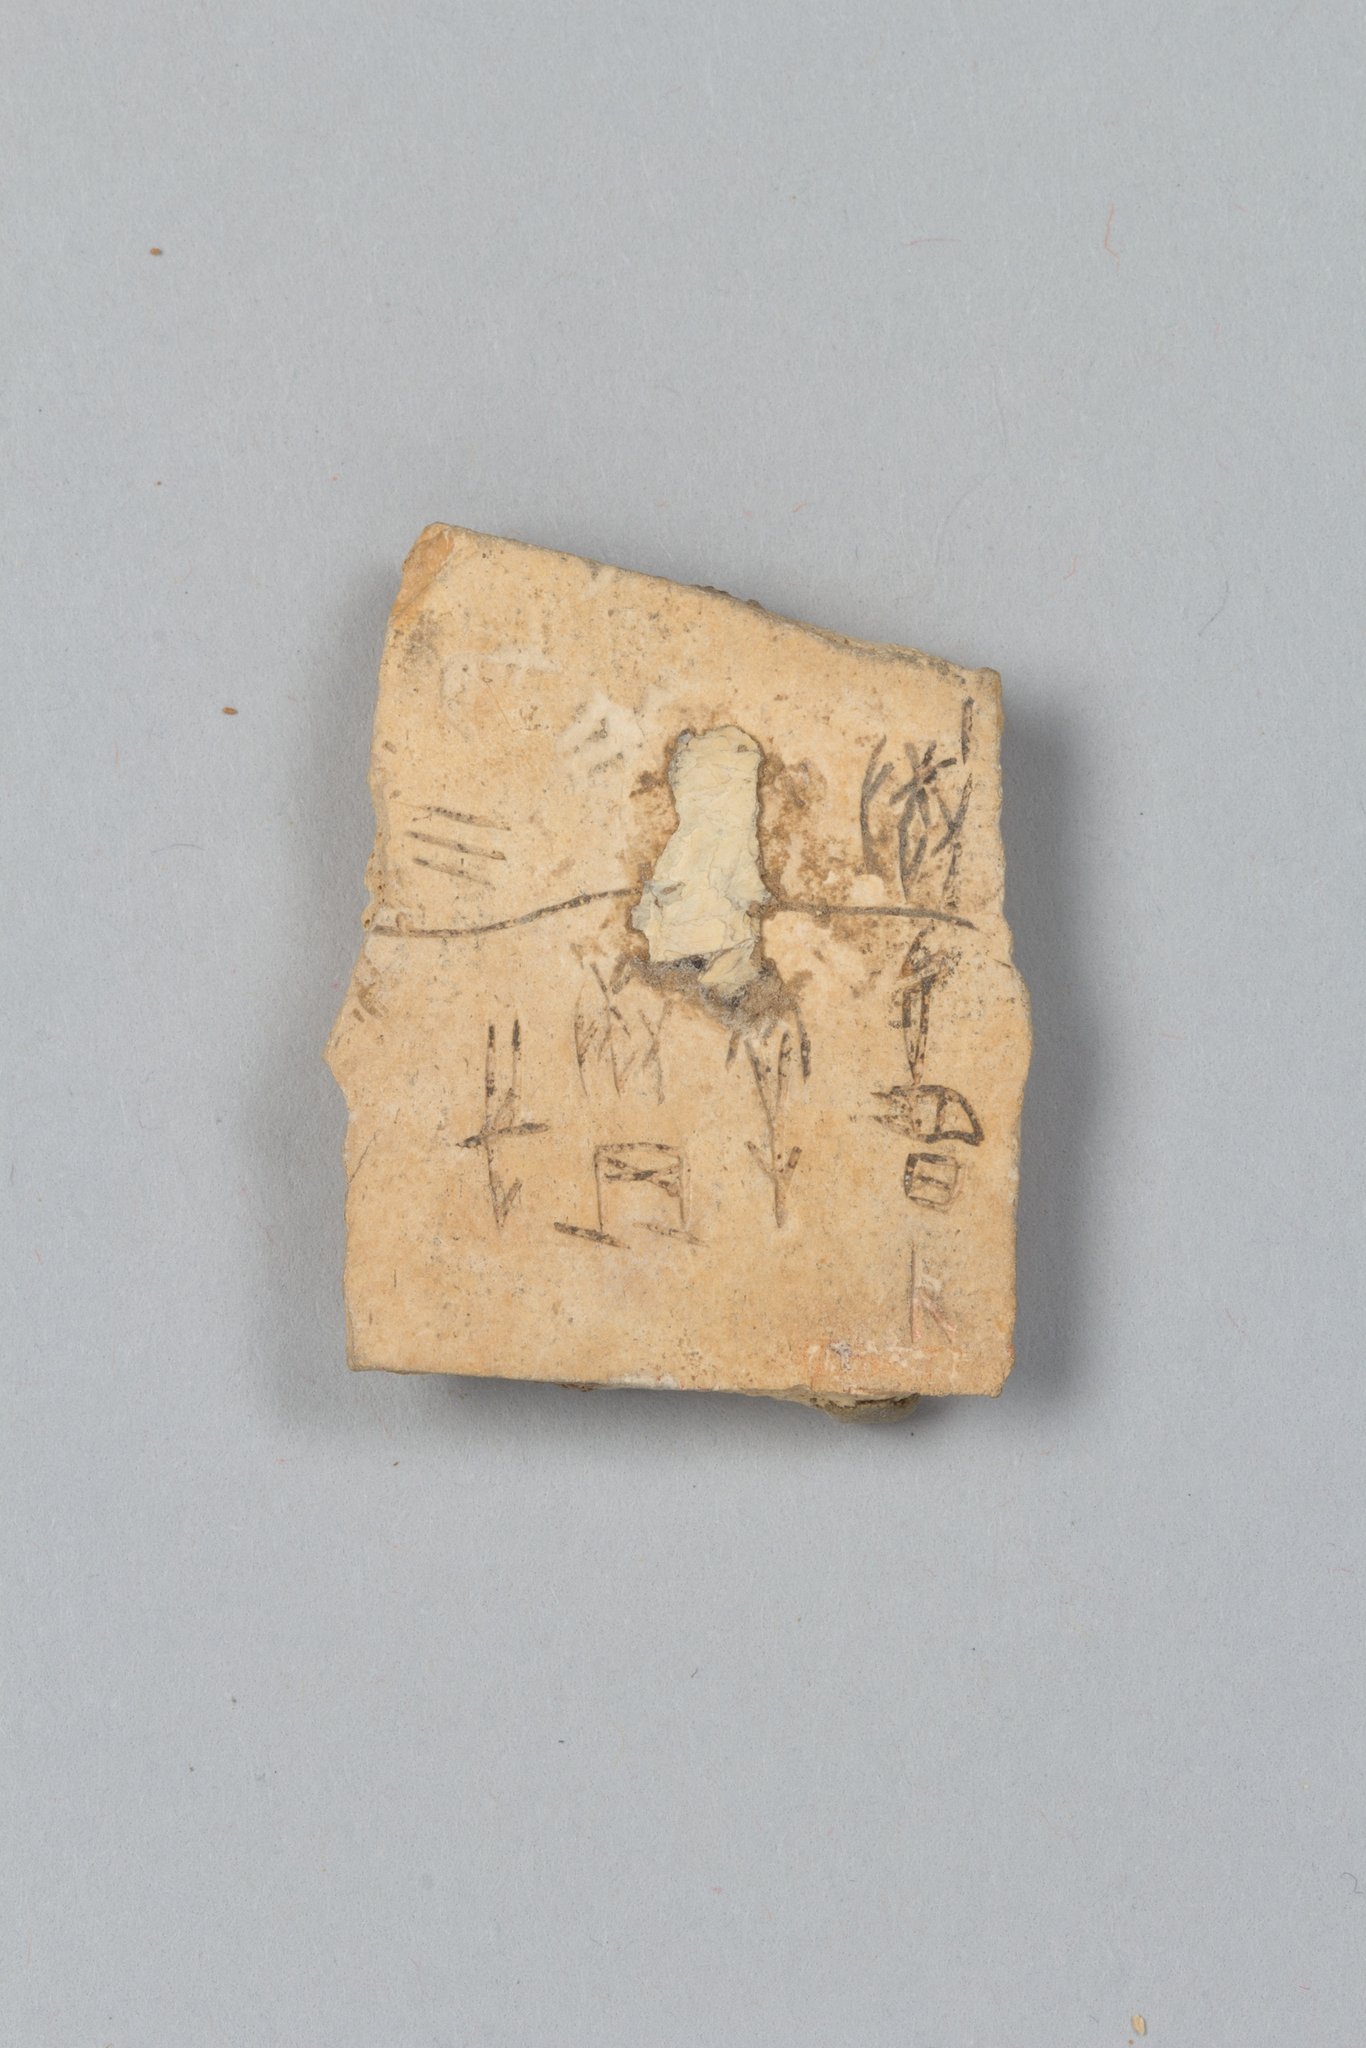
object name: oracle bone fragment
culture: chinese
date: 1600-1046 BCE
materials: bone